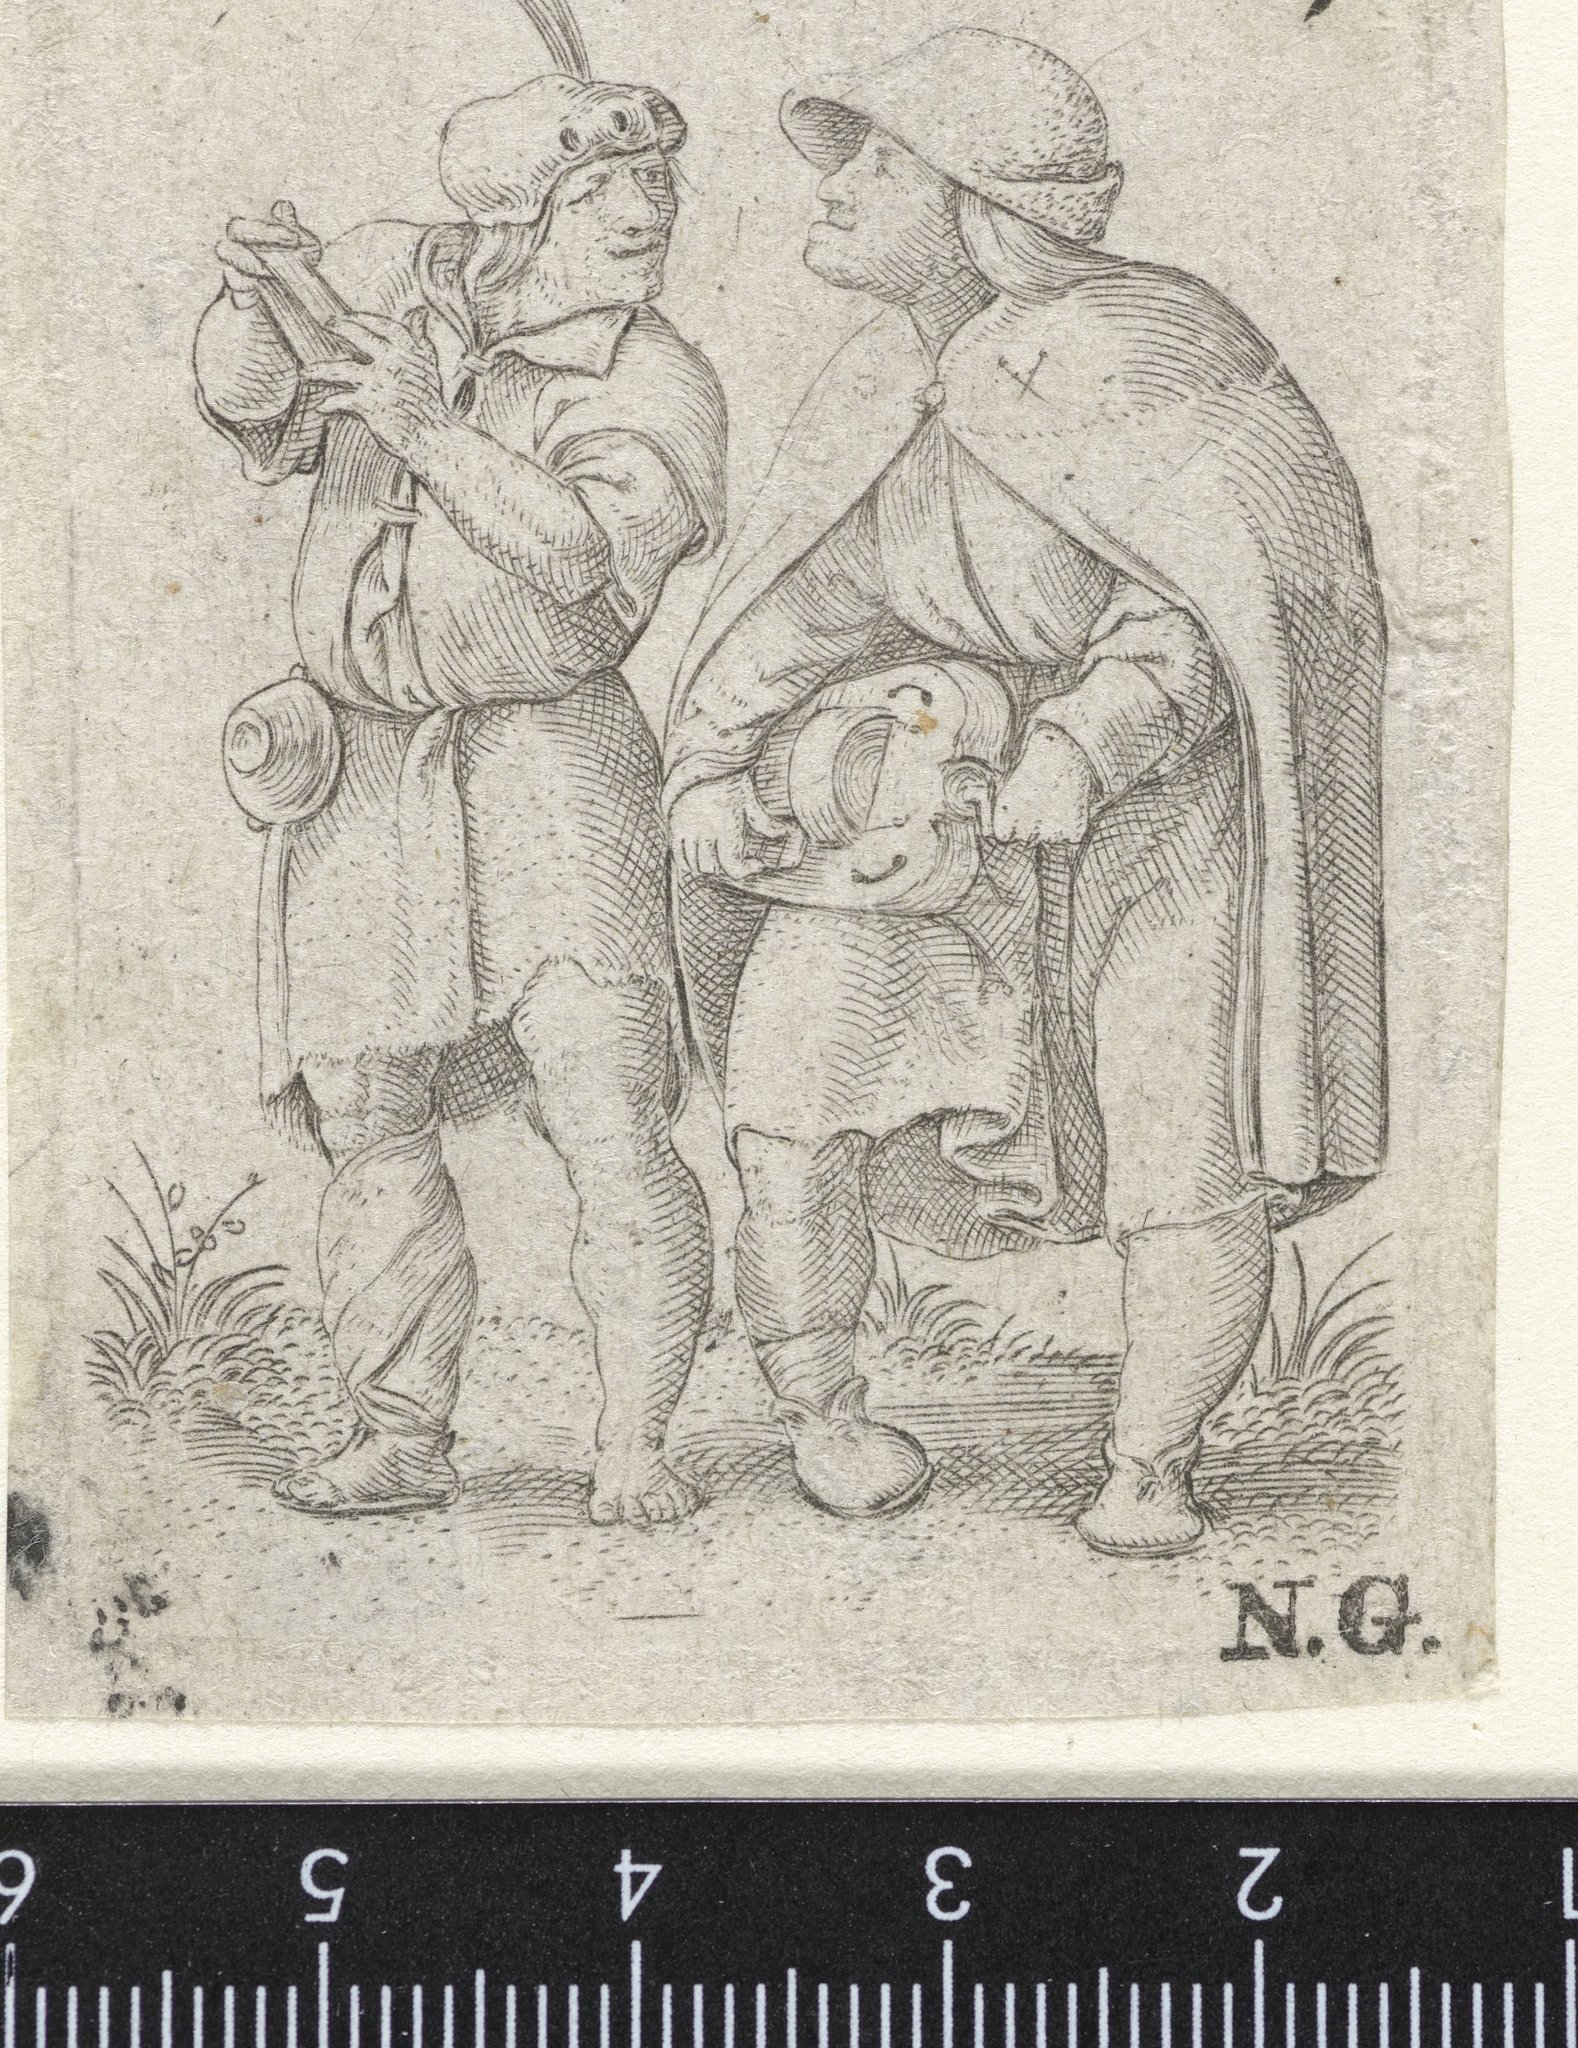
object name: print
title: Dansende kreupelen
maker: cornelis massijs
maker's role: painter, print maker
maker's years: 1510-1557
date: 1577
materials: paper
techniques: engraving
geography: antwerp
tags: dancing, crutches, person with a physical disability, social stratification, social groups, hurdy-gurdy player, folk costume, regional costume, clappers, castanets, beggar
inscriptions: collector's mark: Lugt 1967, collector's mark: Lugt 2227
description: In de tijd waarin deze serie ontstond was 'kreupel' een generiek woord om een lichamelijke beperking aan het onderlichaam te beschrijven. Deze serie is sociale satire. Twee bedelaars, één met castagnetten in de handen en de ander met een draailier. De linker heeft een nap aan zijn riem hangen en een bandage om zijn been. Genummerd: 9.